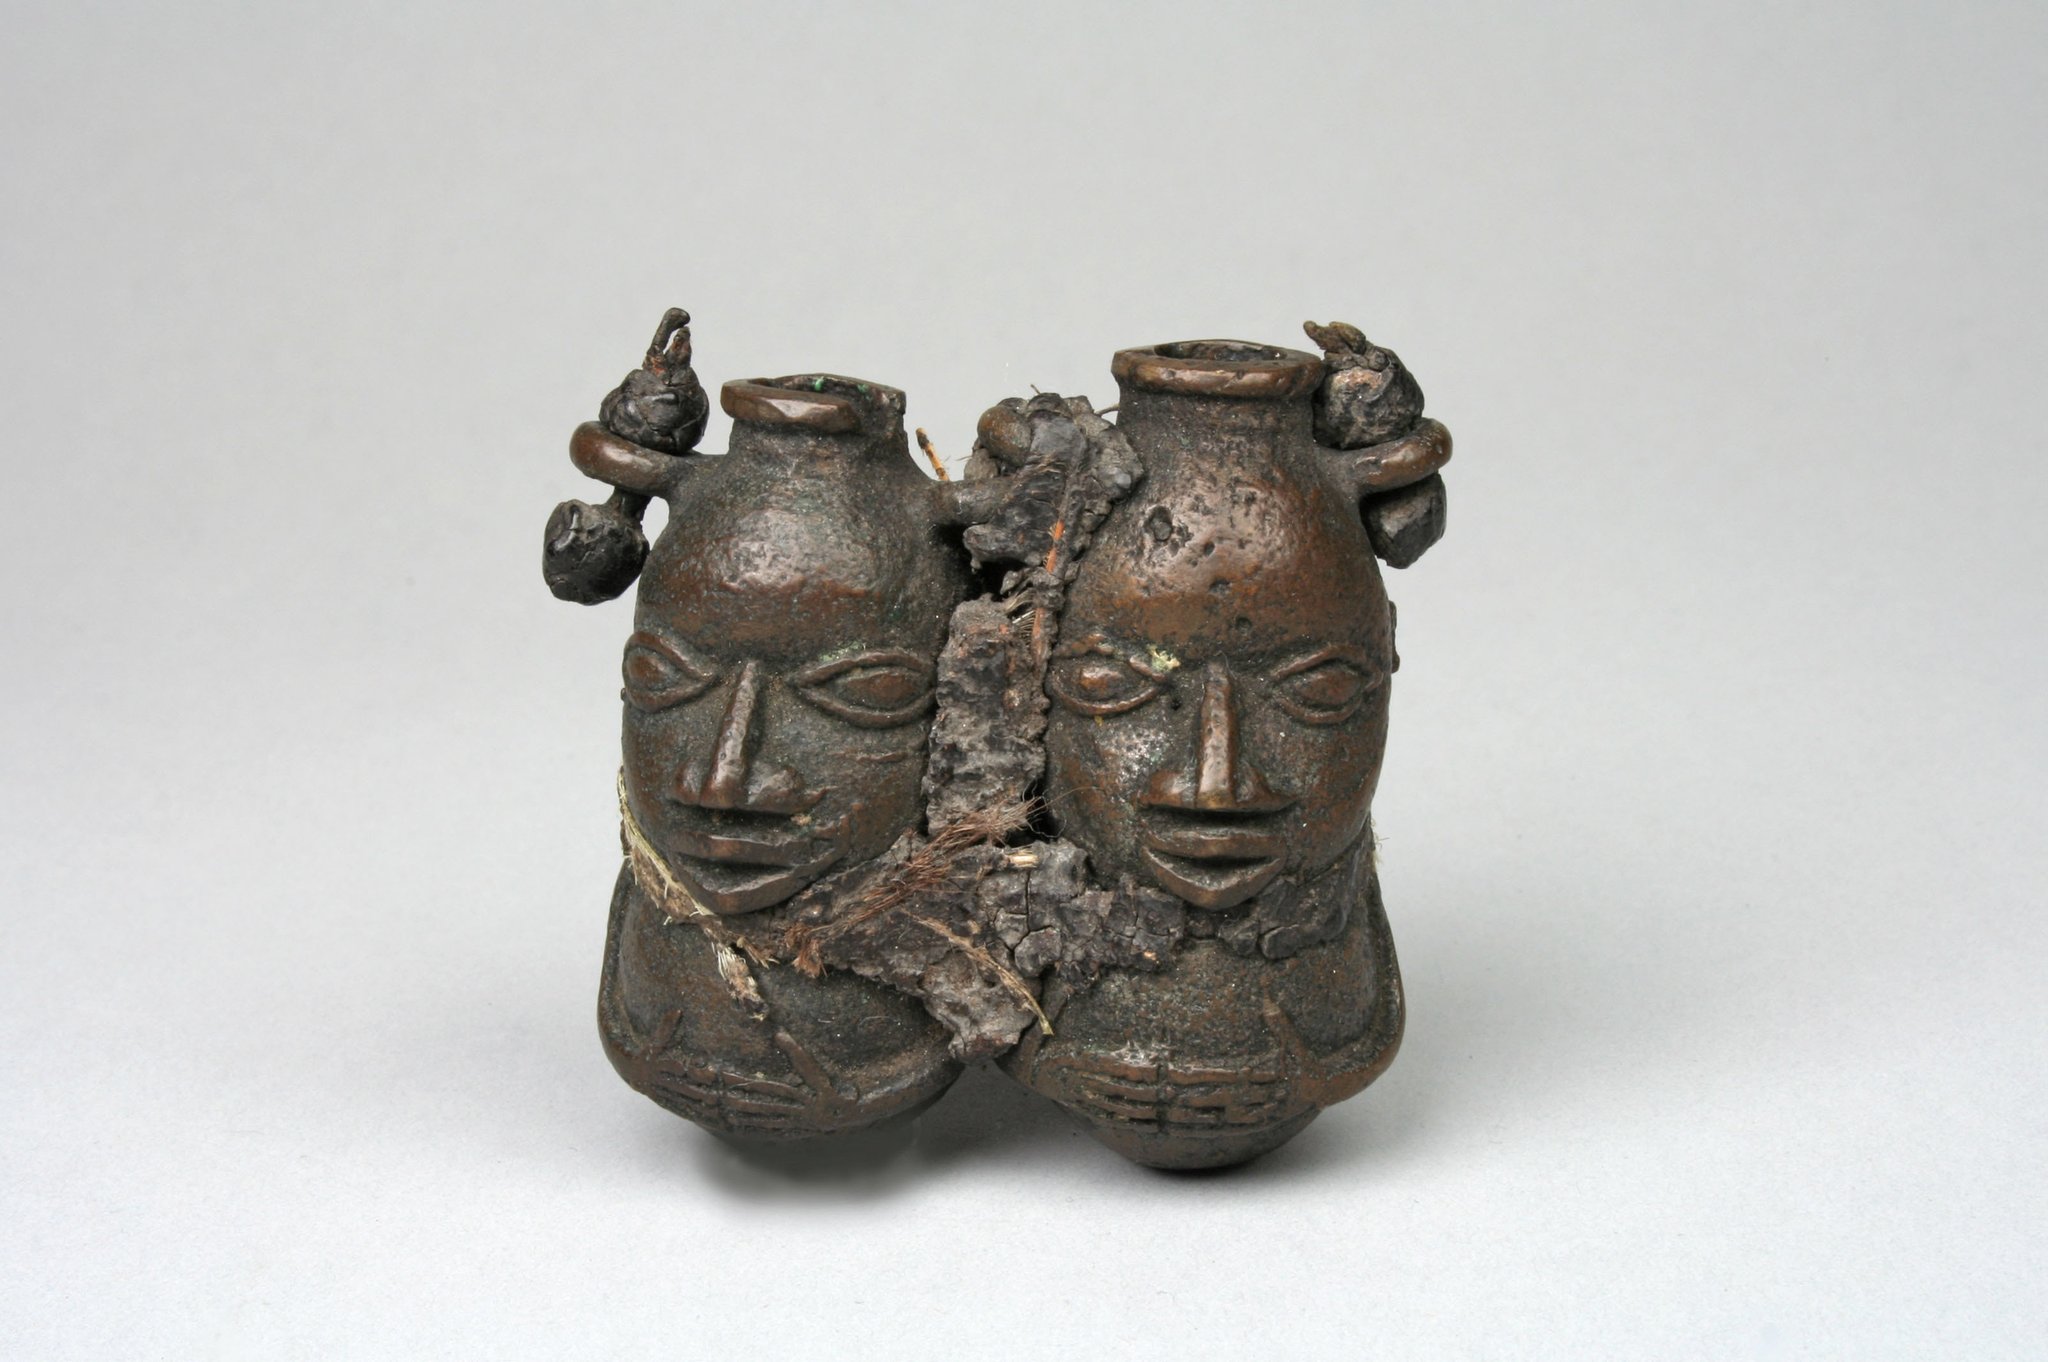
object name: vessel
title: Medicine Vessel: Two Figures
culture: edo period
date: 1701-1900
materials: brass, feather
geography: nigeria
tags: medicine